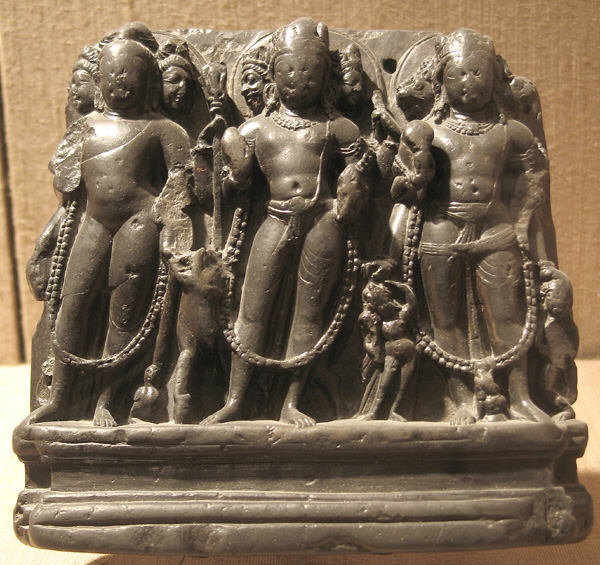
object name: group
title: The Brahmanical Triad: Brahma, Shiva, Vishnu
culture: kashmiri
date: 701-900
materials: stone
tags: kashmir,brahma,shiva,vishnu,hinduism